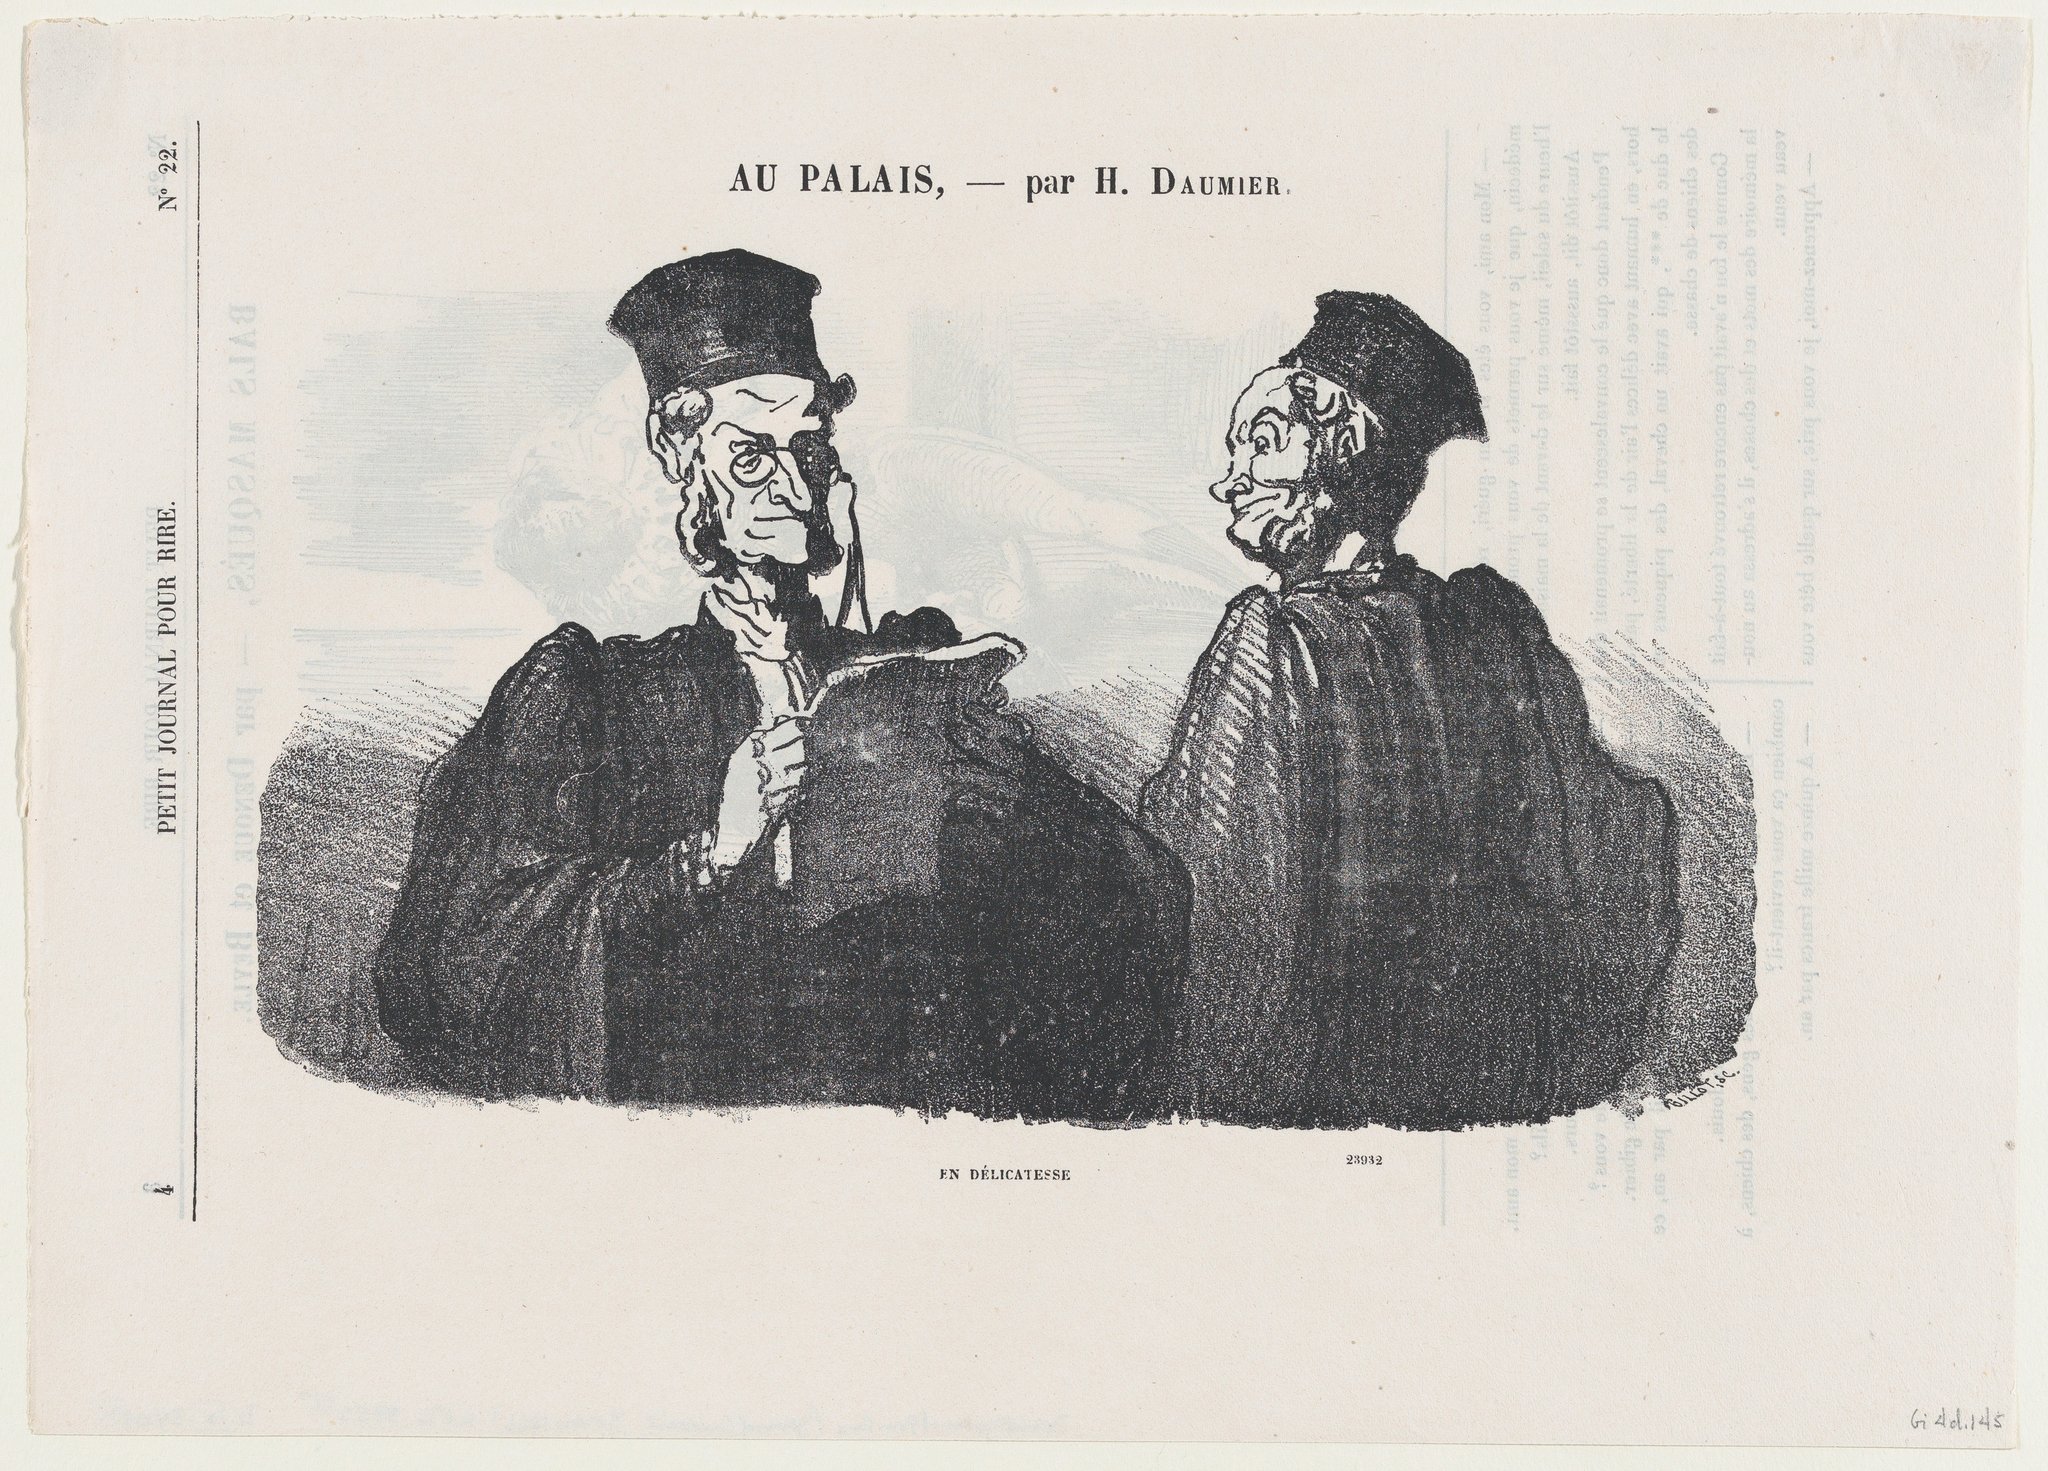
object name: print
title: A slightly strained relationship, from 'At the court of justice,' published in Le Petit Journal pour Rire, March 3, 1866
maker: honoré daumier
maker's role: artist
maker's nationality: french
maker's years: 1808-1879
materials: paper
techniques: lithograph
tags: satire,men,reading